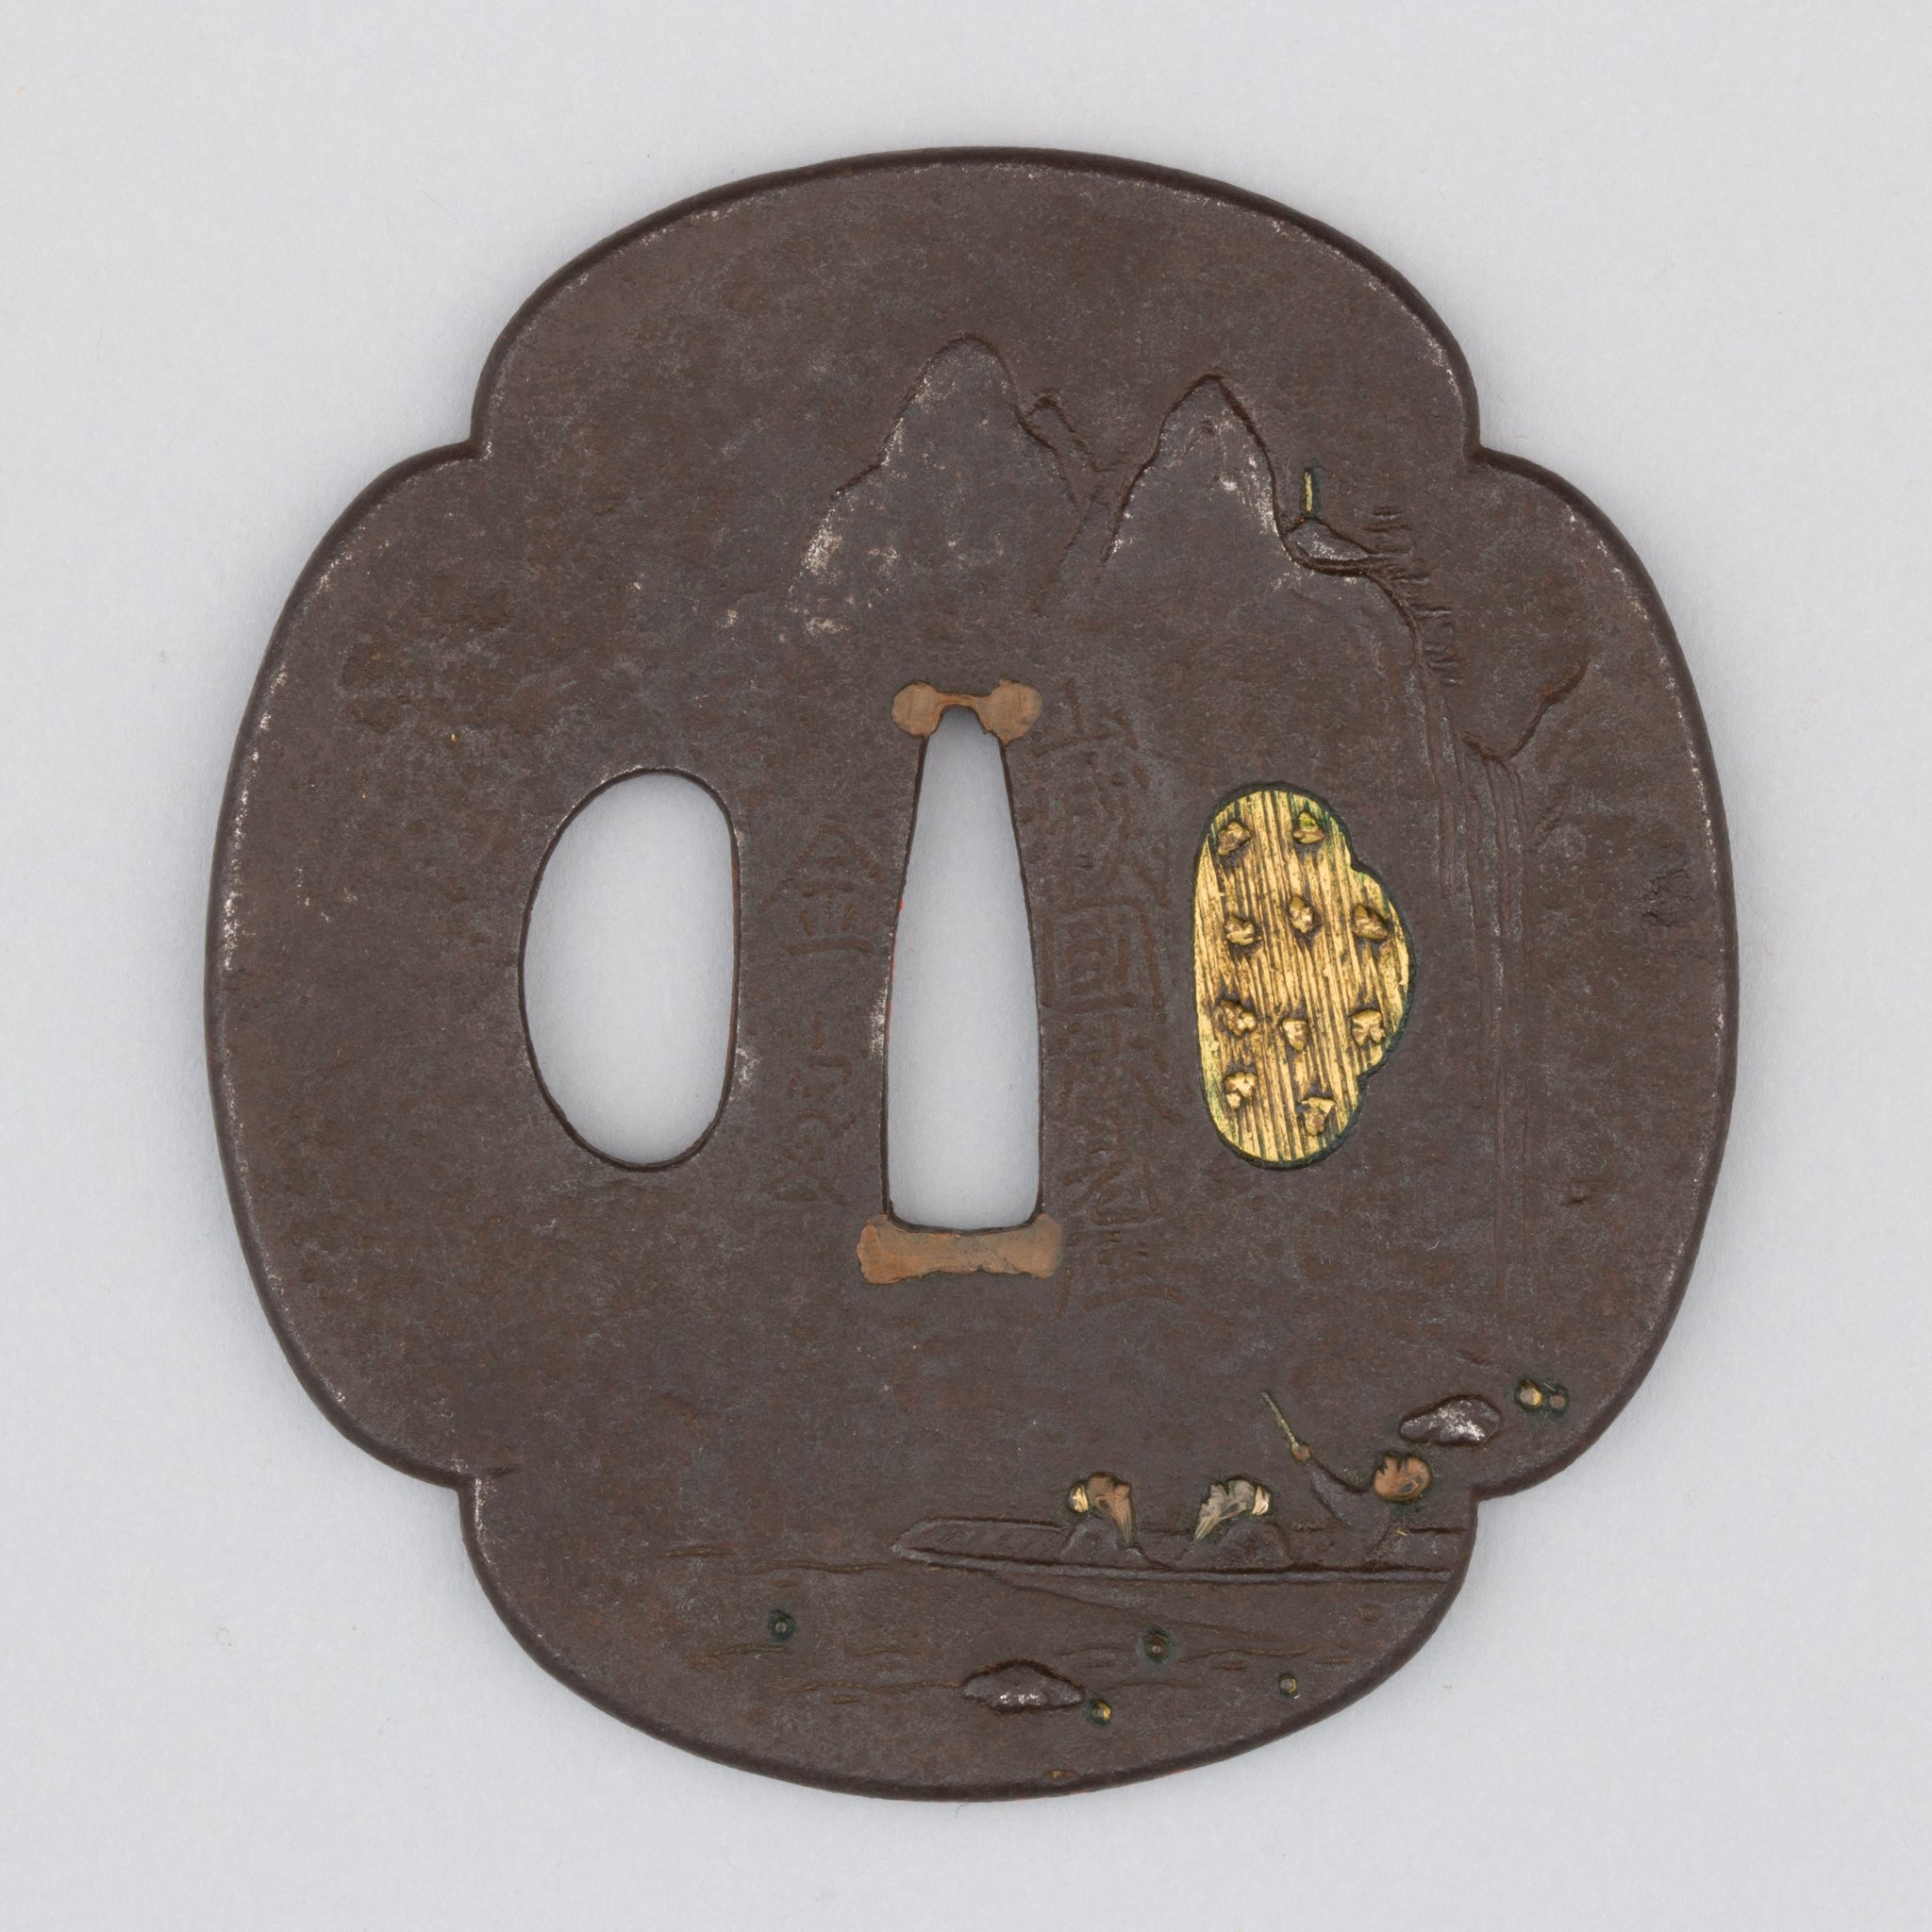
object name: sword guard tsuba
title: Sword Guard (Tsuba)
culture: japanese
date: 1801-1900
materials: copper, iron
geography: japan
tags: men,mountains,boats